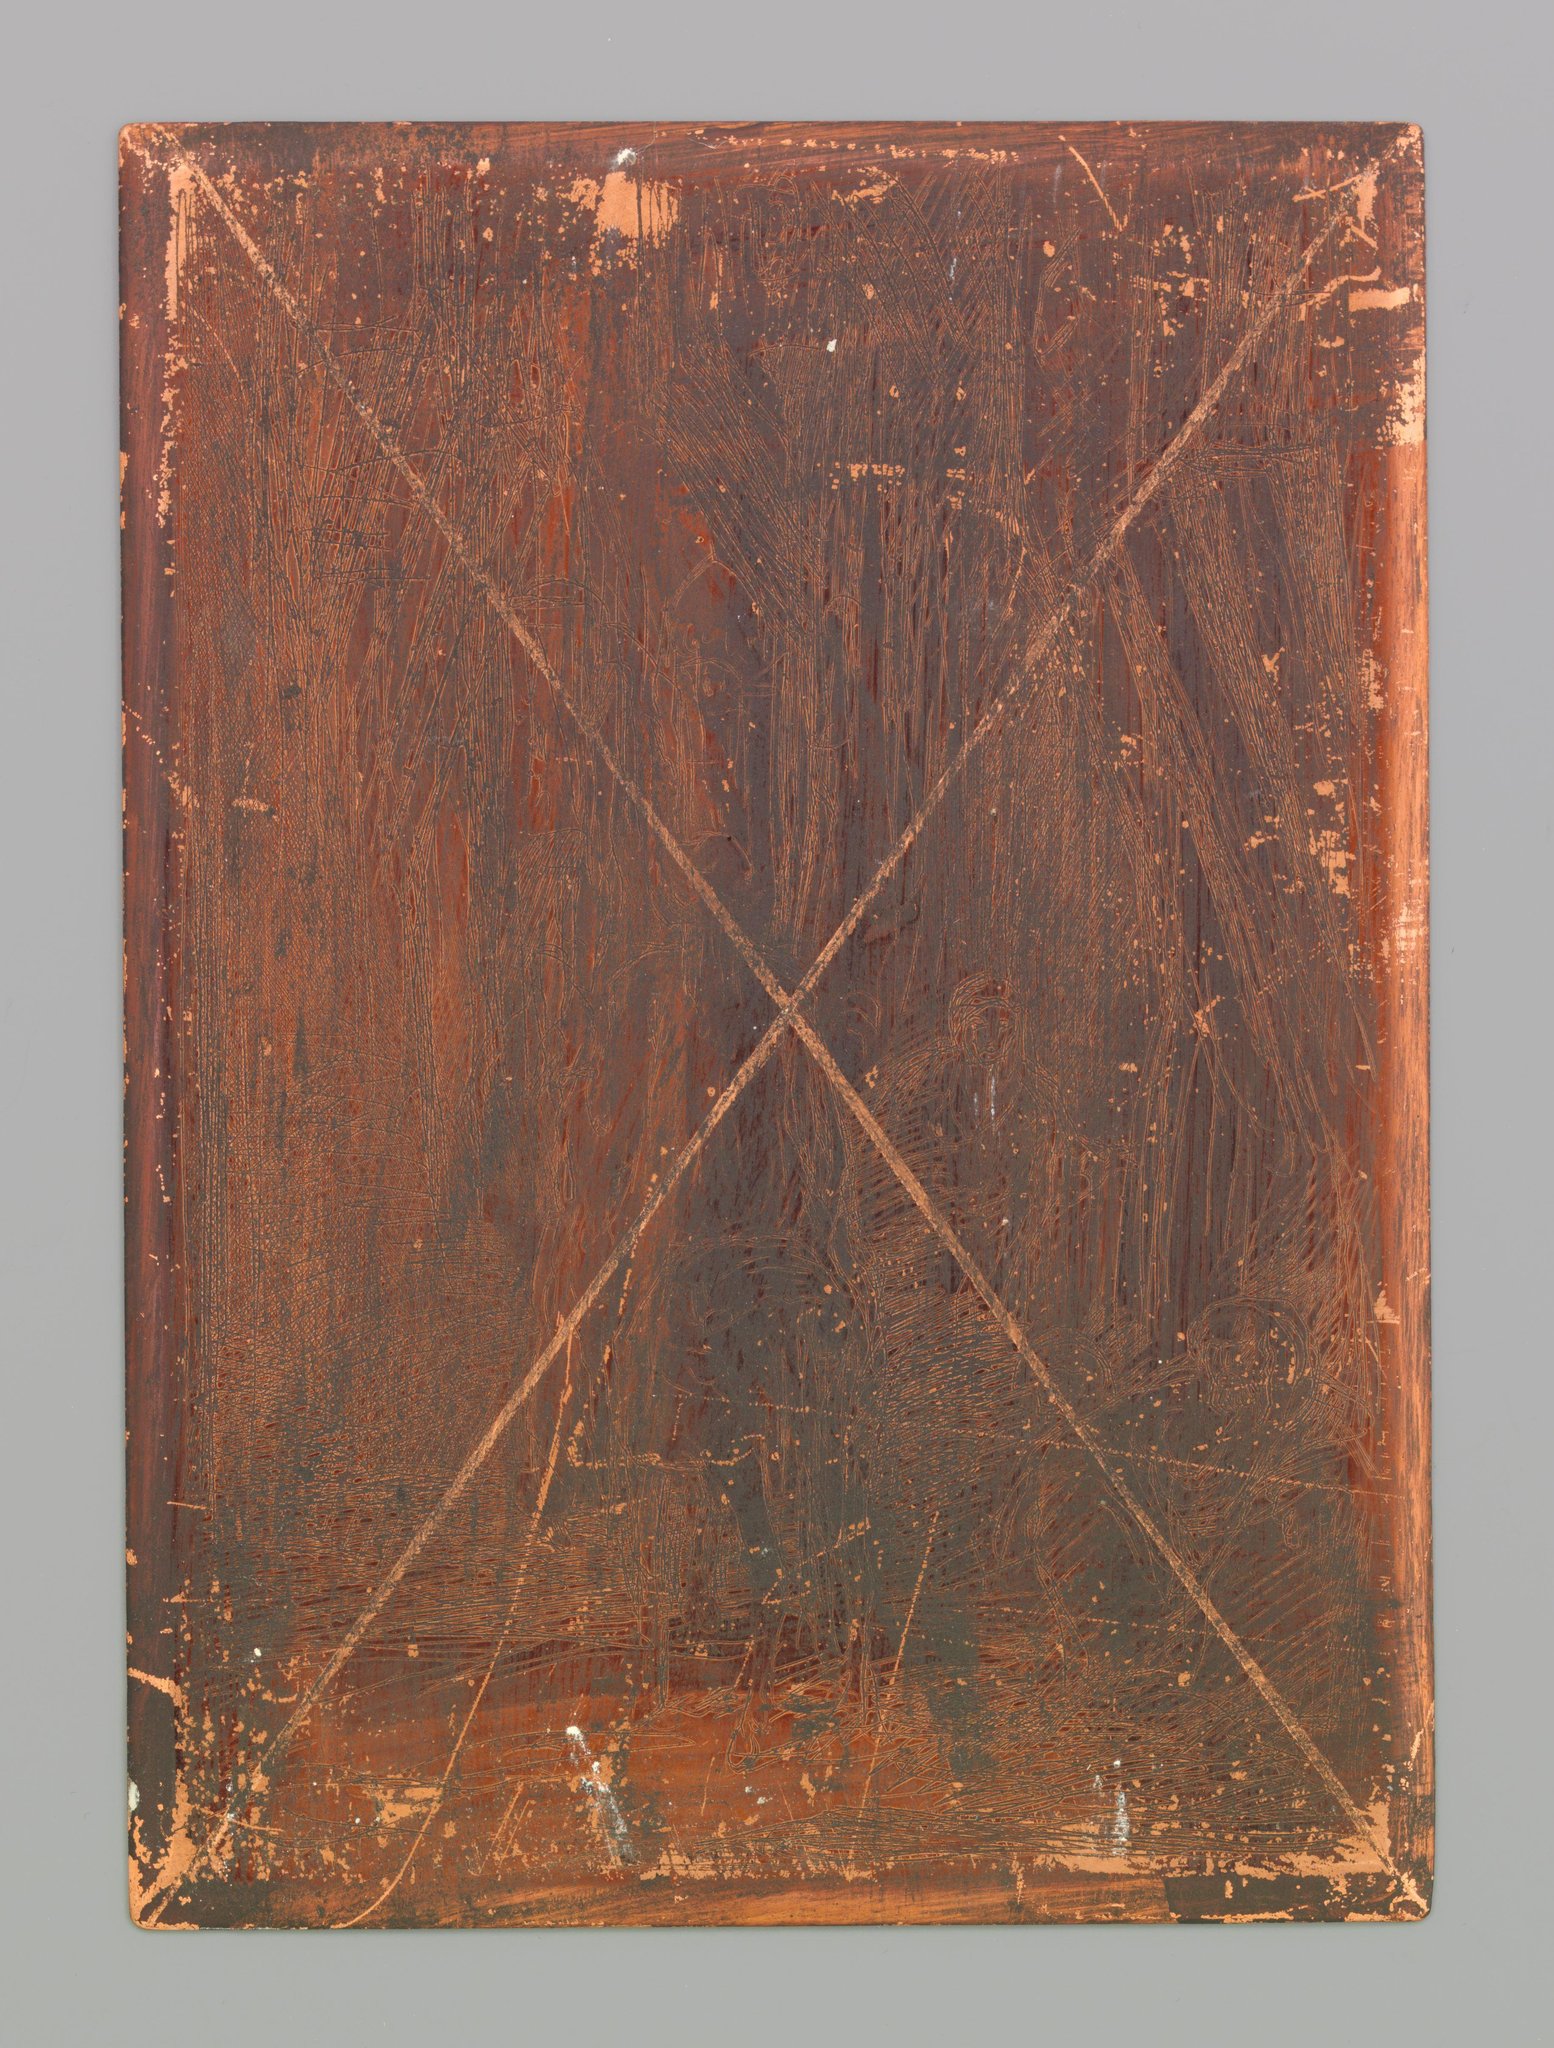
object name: copper plate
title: Straat in Smyrna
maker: marius bauer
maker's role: draughtsman, print maker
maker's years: 1867-1932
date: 1924-1932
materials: copper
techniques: etching